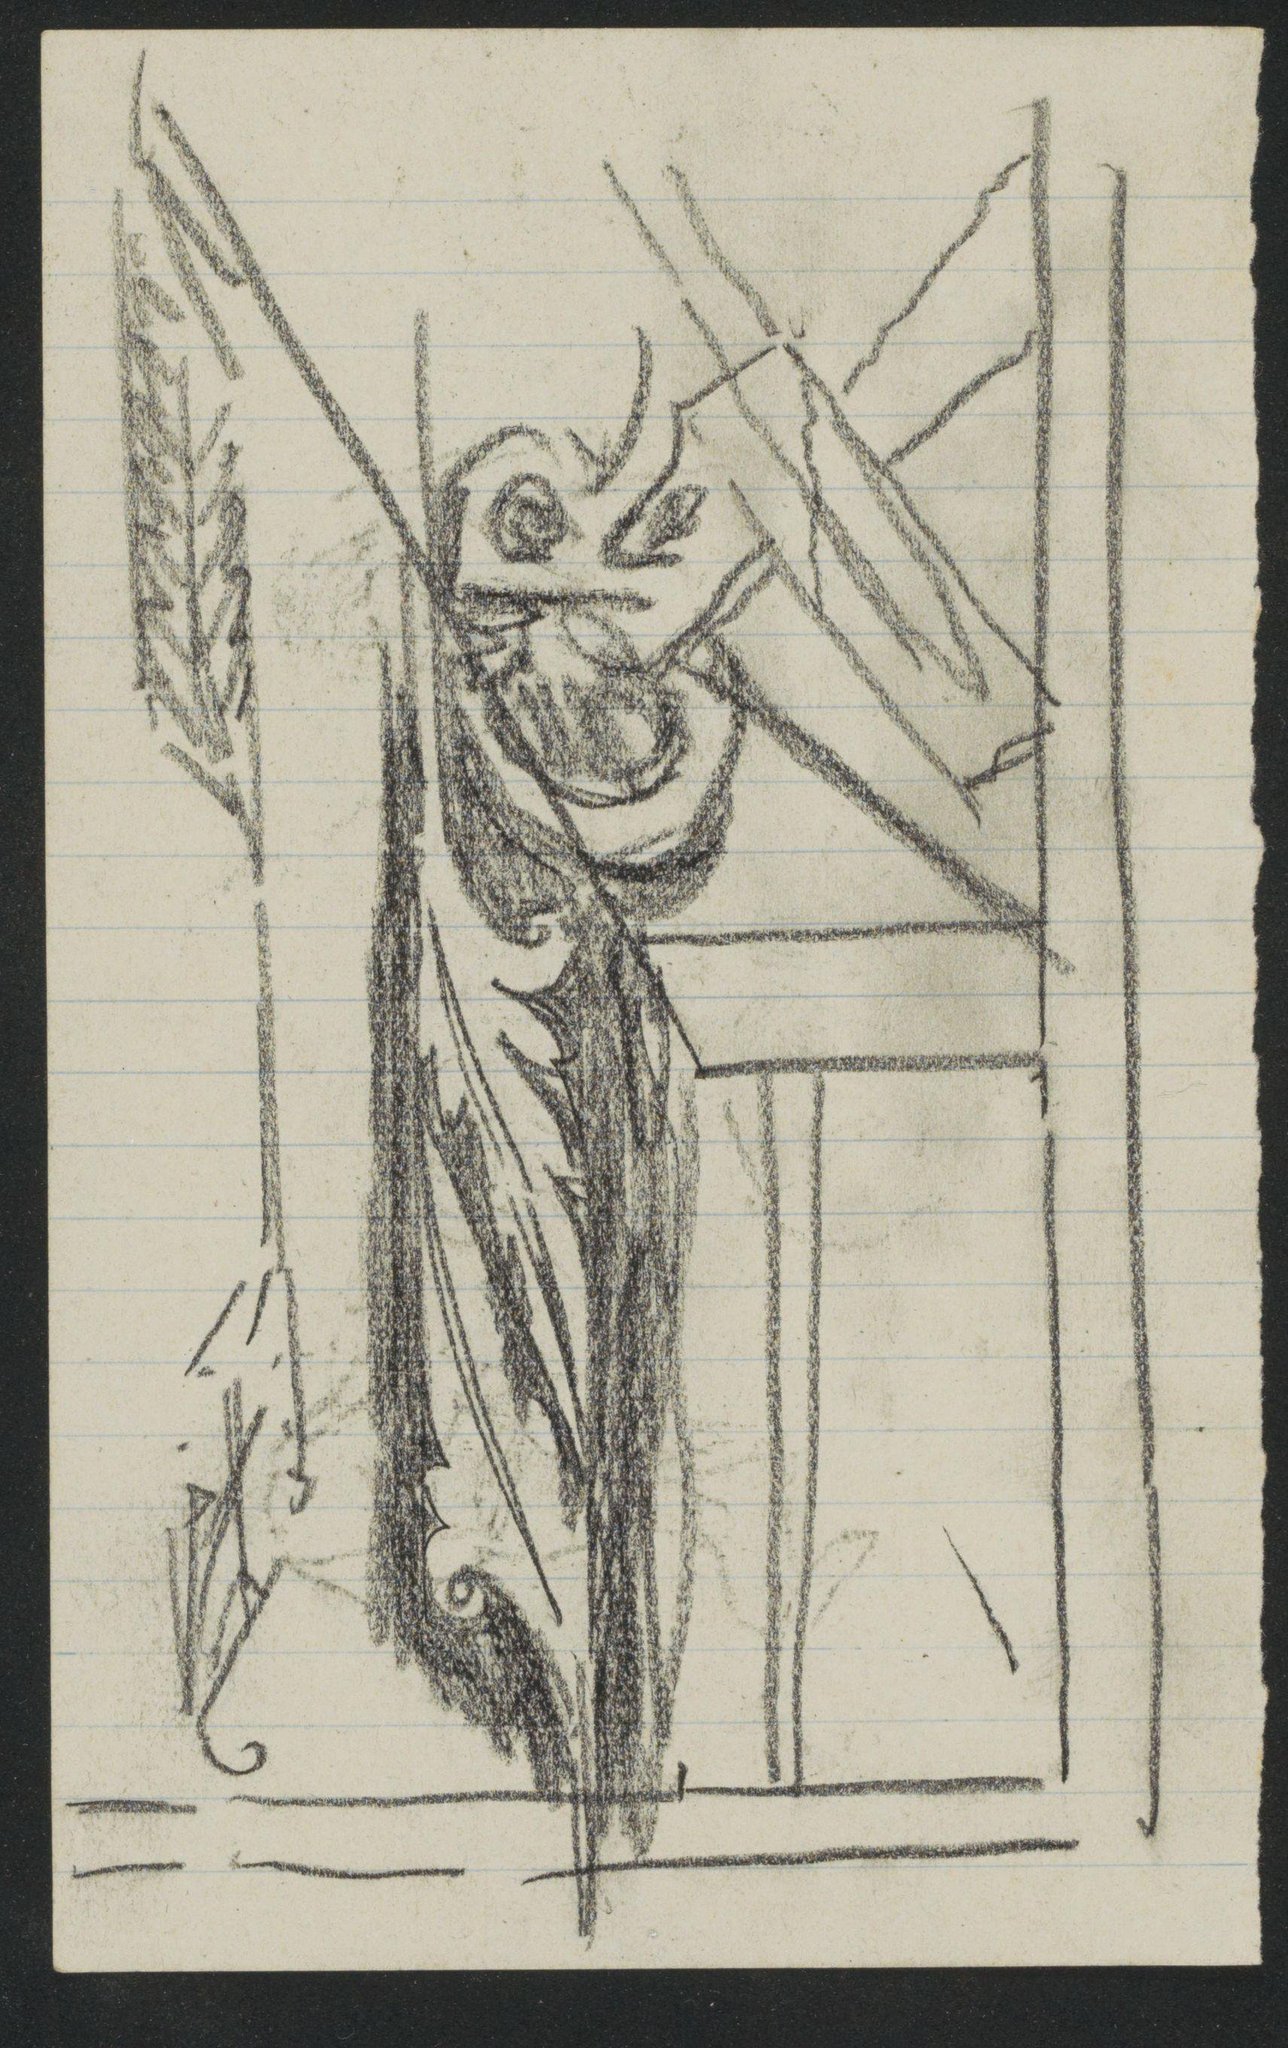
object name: drawing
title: Ornamenten met bladeren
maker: gerrit willem dijsselhof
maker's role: designer, draughtsman, print maker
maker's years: 1866-1924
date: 1876-1924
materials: chalk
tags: foliage, tendrils, branches ~ ornament